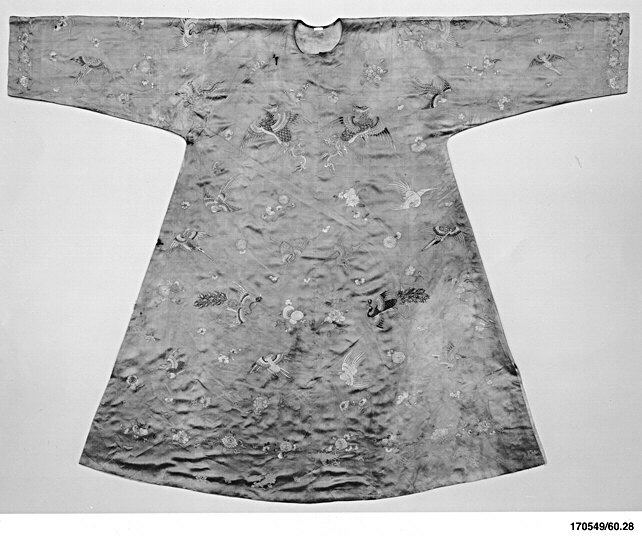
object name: woman's informal robe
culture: chinese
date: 1701-1800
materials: metal thread, silk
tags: birds